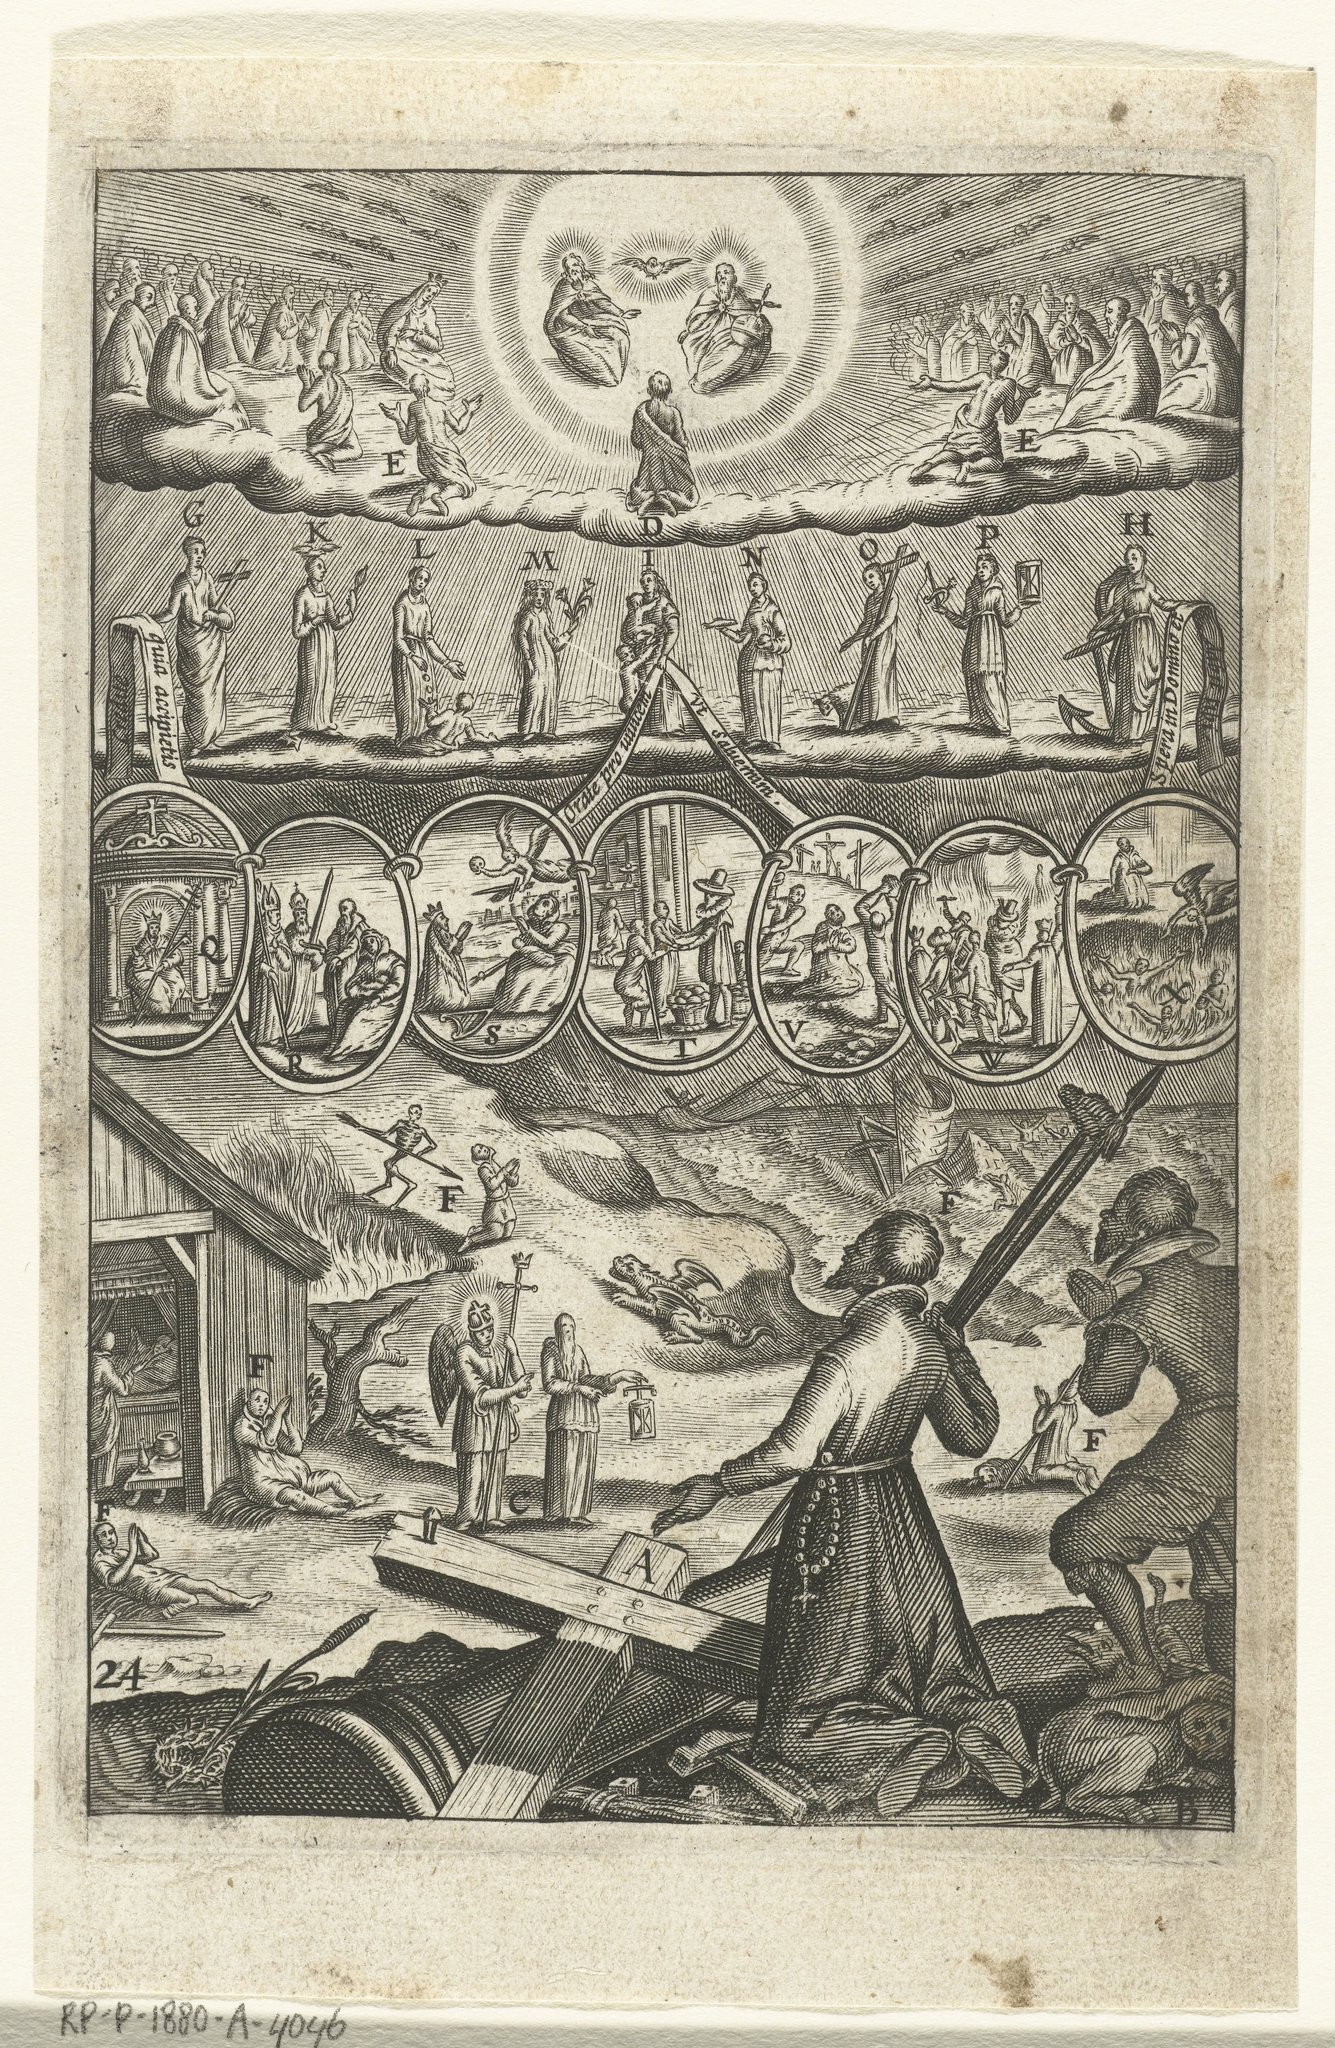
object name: print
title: Den wech des eeuwich levens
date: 1620-1623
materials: paper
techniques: engraving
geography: antwerp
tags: 'sapientia' and the seven virtues, i.e. the three theological and the four cardinal virtues, the holy trinity, 'trinitas coelestis'; father, son and holy ghost ~ christian religion, the life of man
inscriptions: collector's mark: Lugt 2228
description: Een geestelijke knielt in gebed met de passiewerktuigen van Christus, een man naast hem knielt eveneens in gebed en vertrapt de duivel. Zij richten zich tot God die troont in de hemel en de heiligen die voorspraak kunnen doen. Op zeven schilden zijn de deugden weergegeven die de meditatie voorschrijft en welke de mens tijdens zijn leven moet nastreven: geloof, hoop, liefde, rechtvaardigheid, matigheid, kracht en voorzichtigheid.